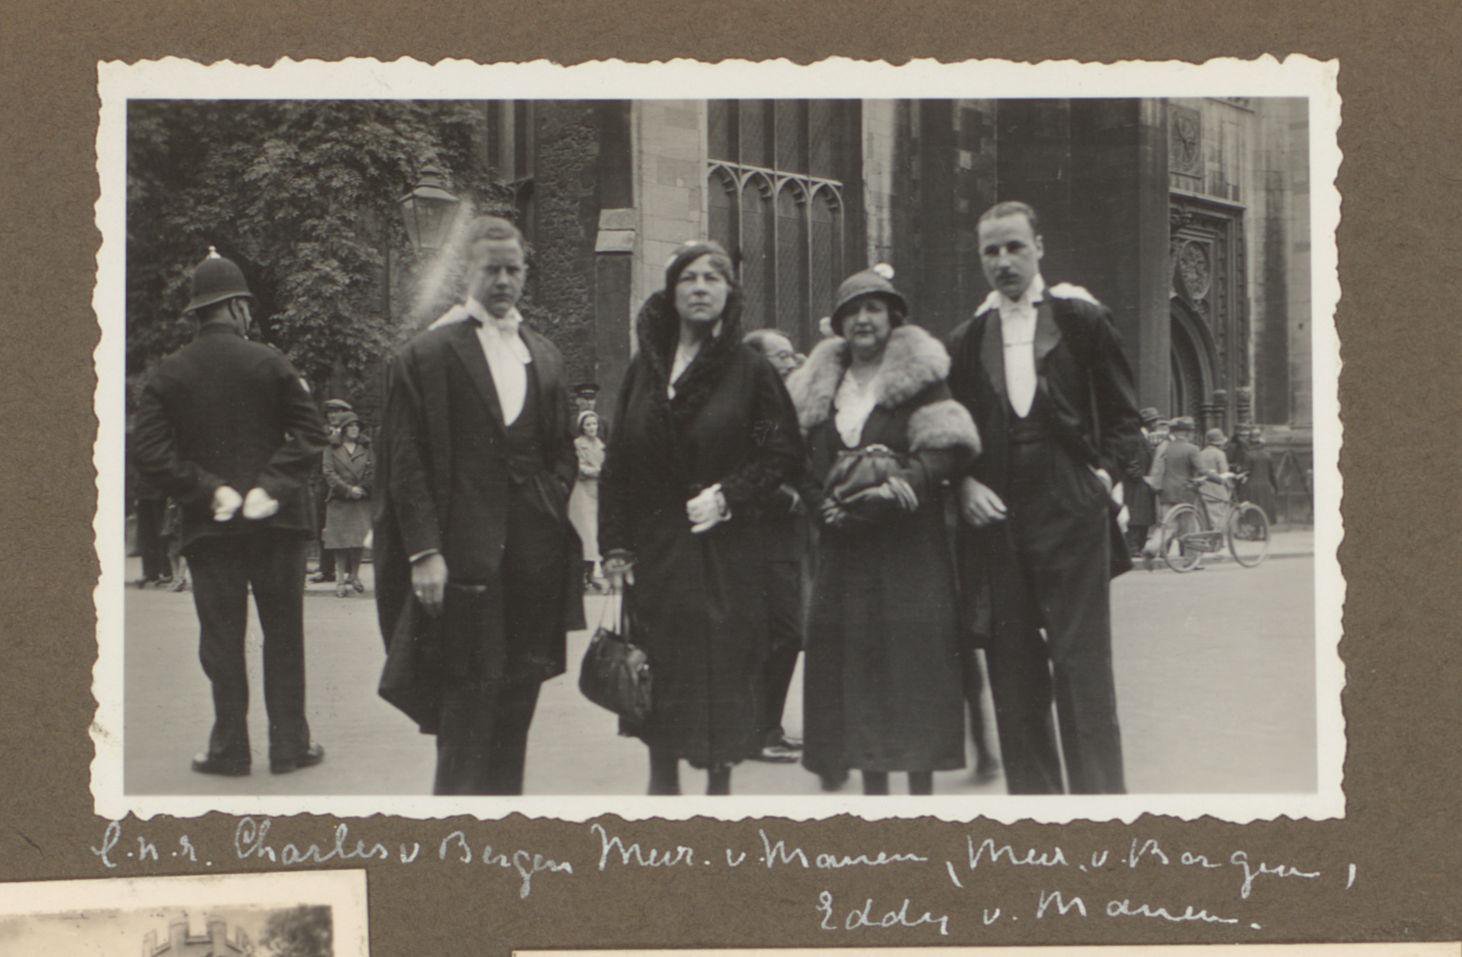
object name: album leaf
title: Groepsportret van Charles van Bergen, mevrouw Van Manen, Henriëtte van Bergen en Eddy van Manen, Cambridge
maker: Anonymous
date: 1906-1932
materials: paper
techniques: gelatin silver print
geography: cambridge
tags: palembang (city), university diploma, historical persons, student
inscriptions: inscription: ‘l.n.r. Charles v. Bergen, Mevr. v. Manen, Mevr. v. Bergen,/ Eddy v. Manen.’